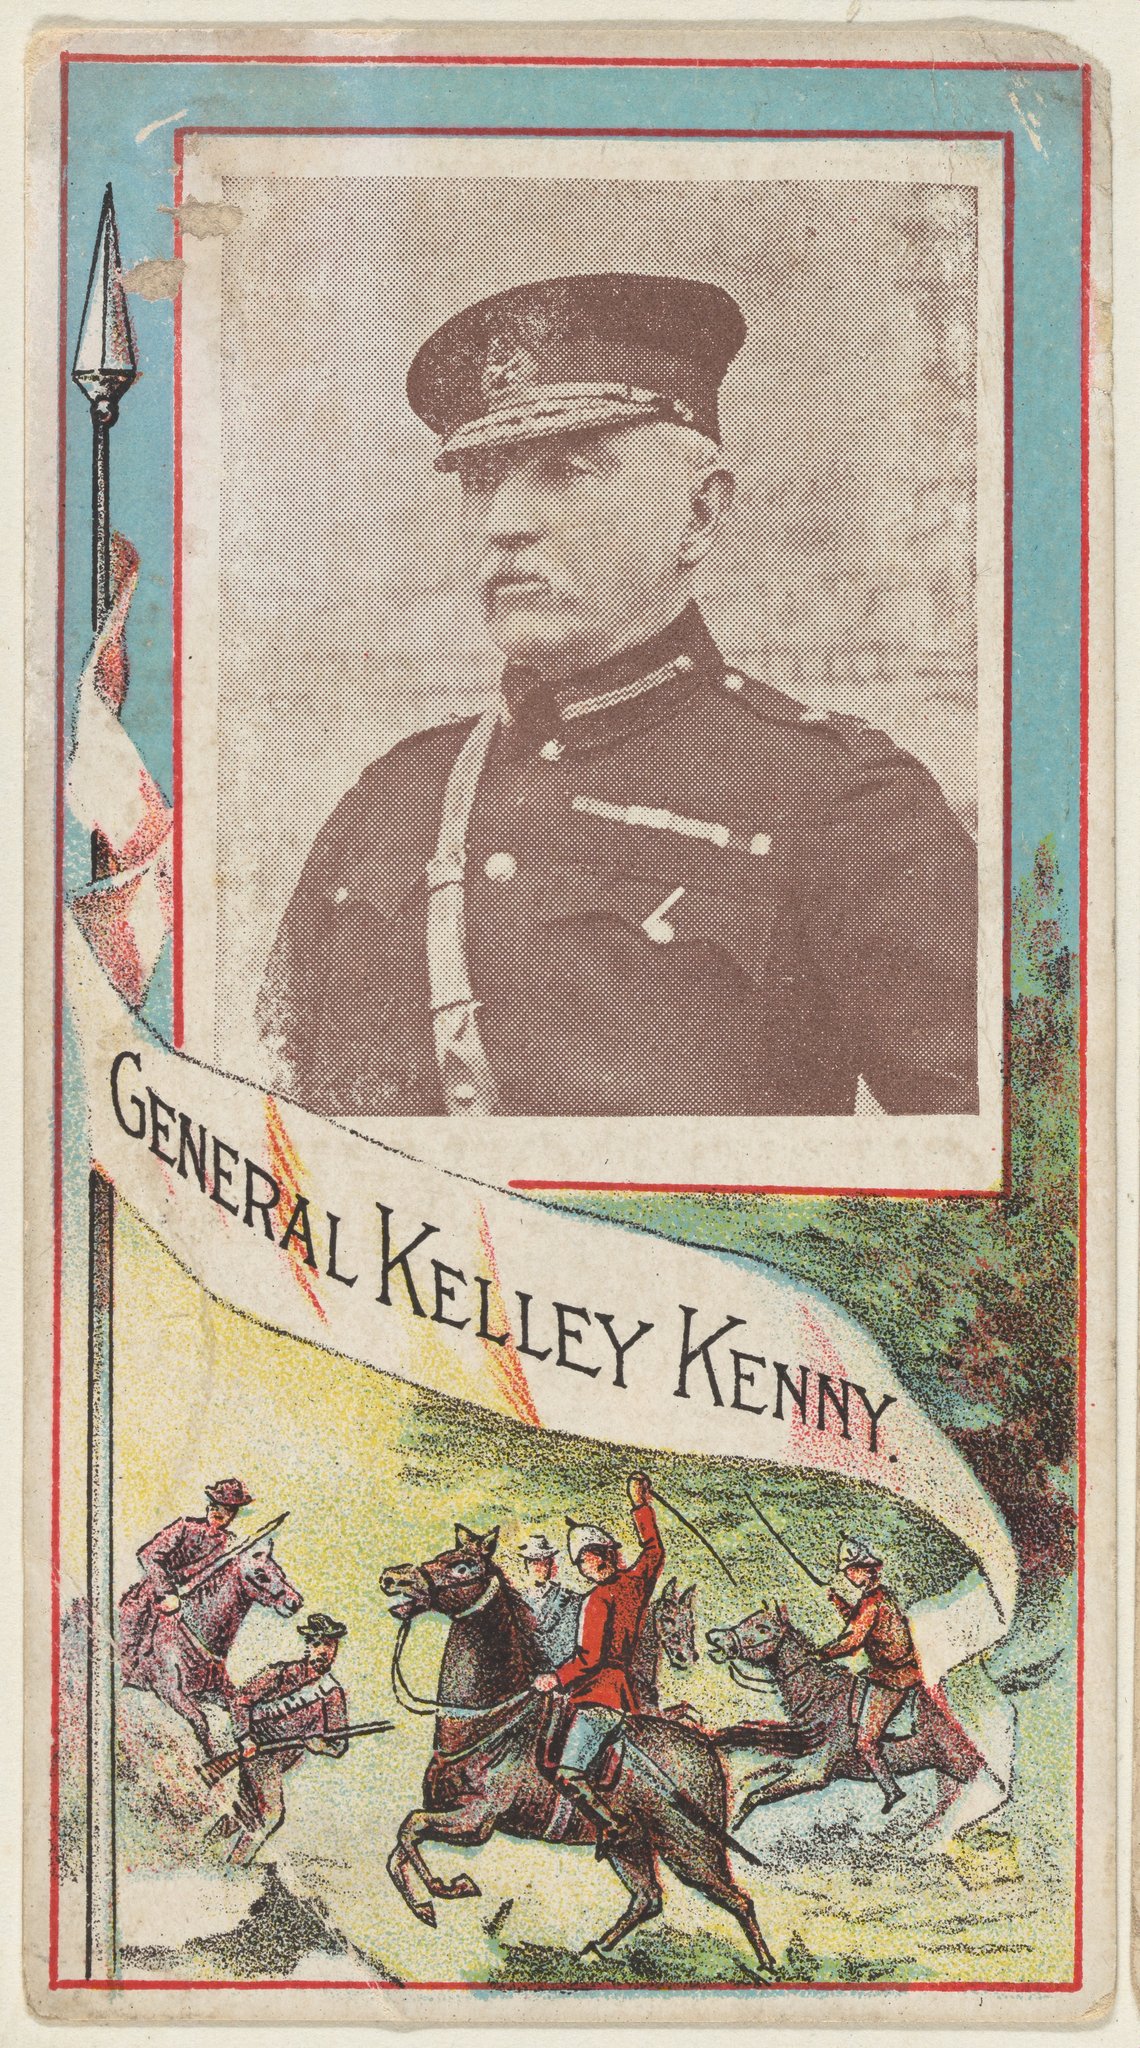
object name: print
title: General Kelley Kenny, from the "Generals" series (T64), issued by D.H. McAlpin & Co. Tobacco Company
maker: d.h. mcalpin & co. tobacco company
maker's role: publisher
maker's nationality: american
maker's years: 1857-1901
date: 1901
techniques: color lithograph